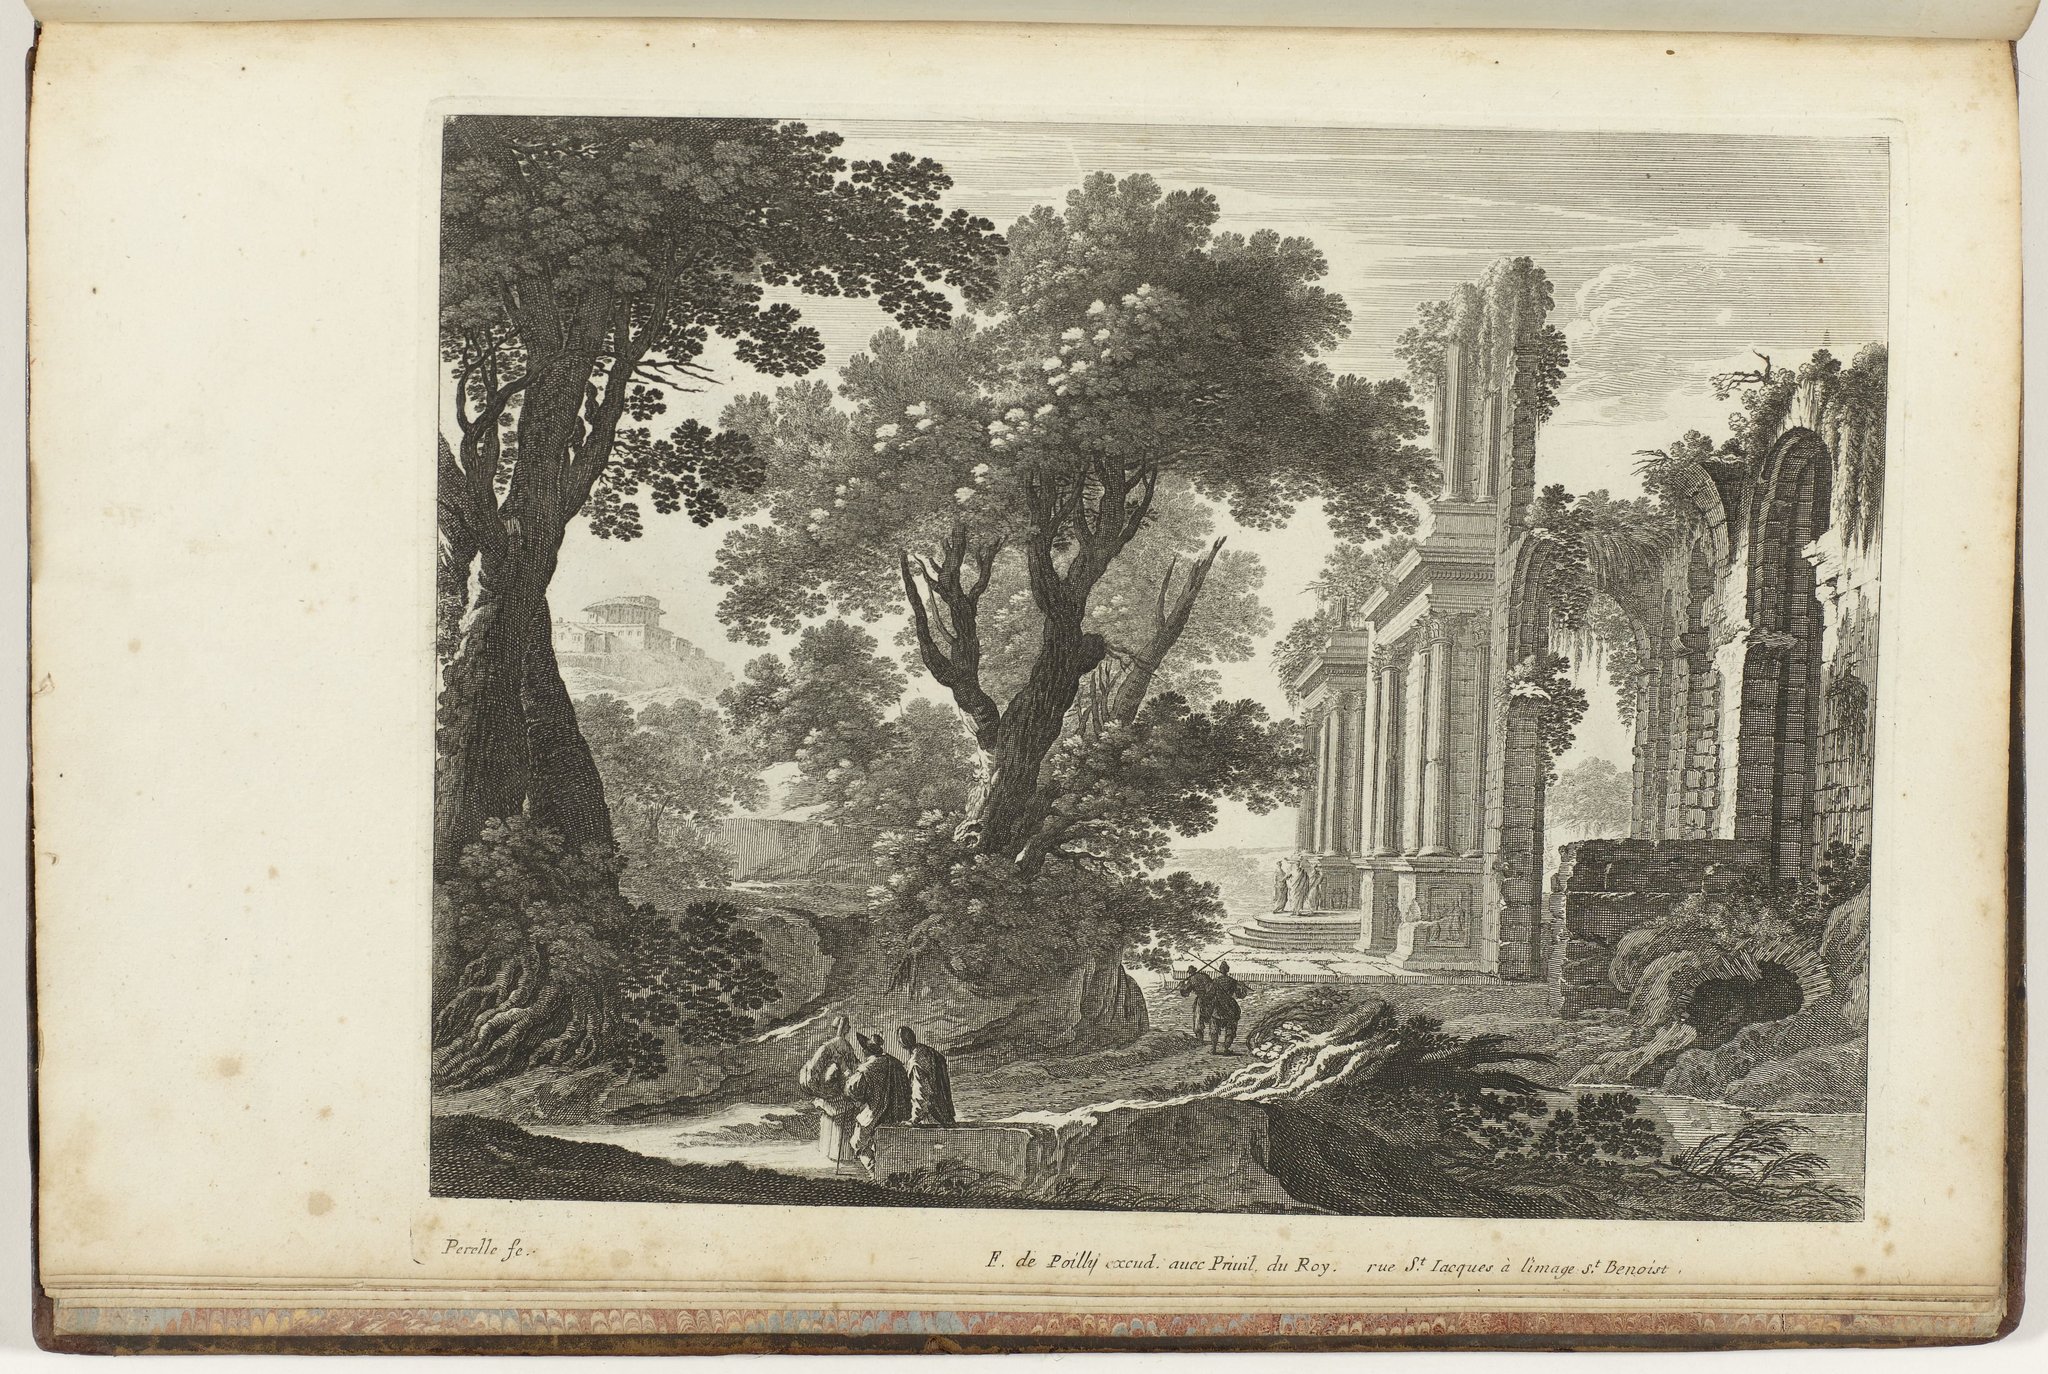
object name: album leaf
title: Landschap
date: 1680-1695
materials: paper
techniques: etching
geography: paris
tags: landscape with ruins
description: Landschap. Ontwerp voor schildering boven schoorsteenmantel of deur? Prent maakt deel uit van een album.